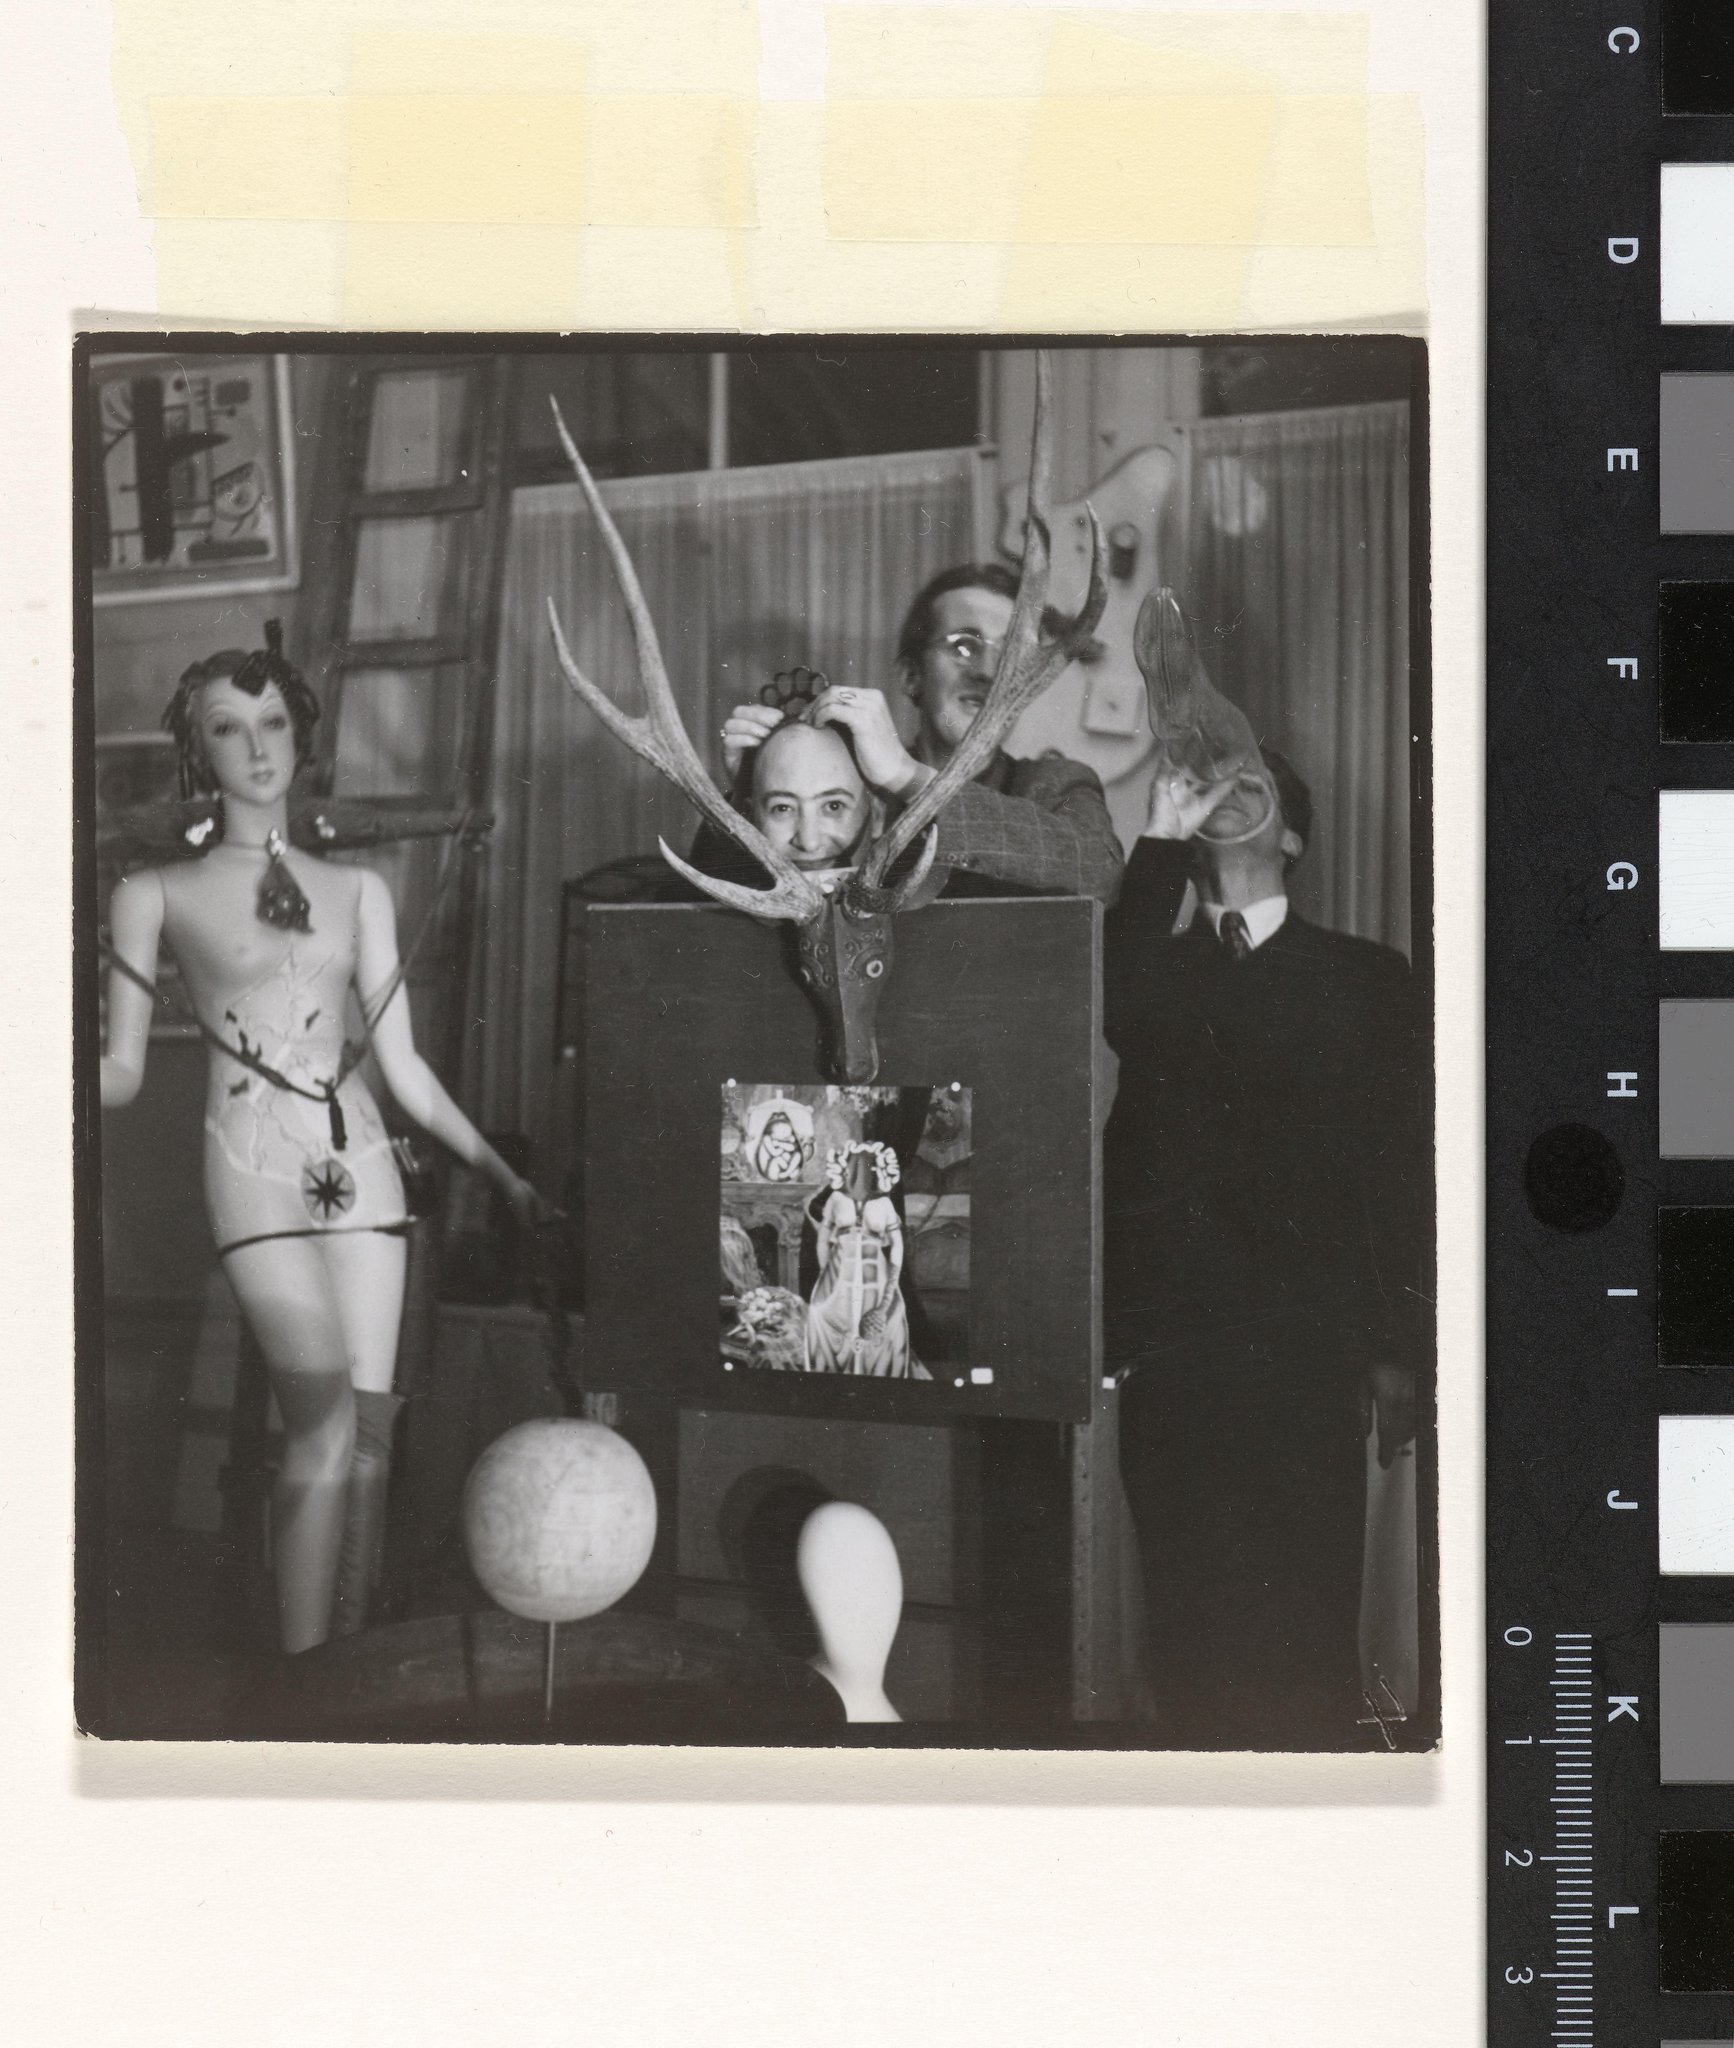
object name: photograph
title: Demonstratie van drie heren met gewei en schilderij tijdens de opening van de tentoonstelling in Galerie Robert in Amsterdam 1938 Exposition Internationale du Surrealisme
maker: lilly samuel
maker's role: fotograaf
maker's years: 1909-1944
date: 1938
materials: photographic support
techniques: gelatin silver print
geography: amsterdam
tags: amsterdam, paris, draughtsman, tonny kristians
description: Onderdeel van een serie betreffende een reizende tentoonstelling "Exposition Internationale du Surréalisme", in galerie Robert te Amsterdam